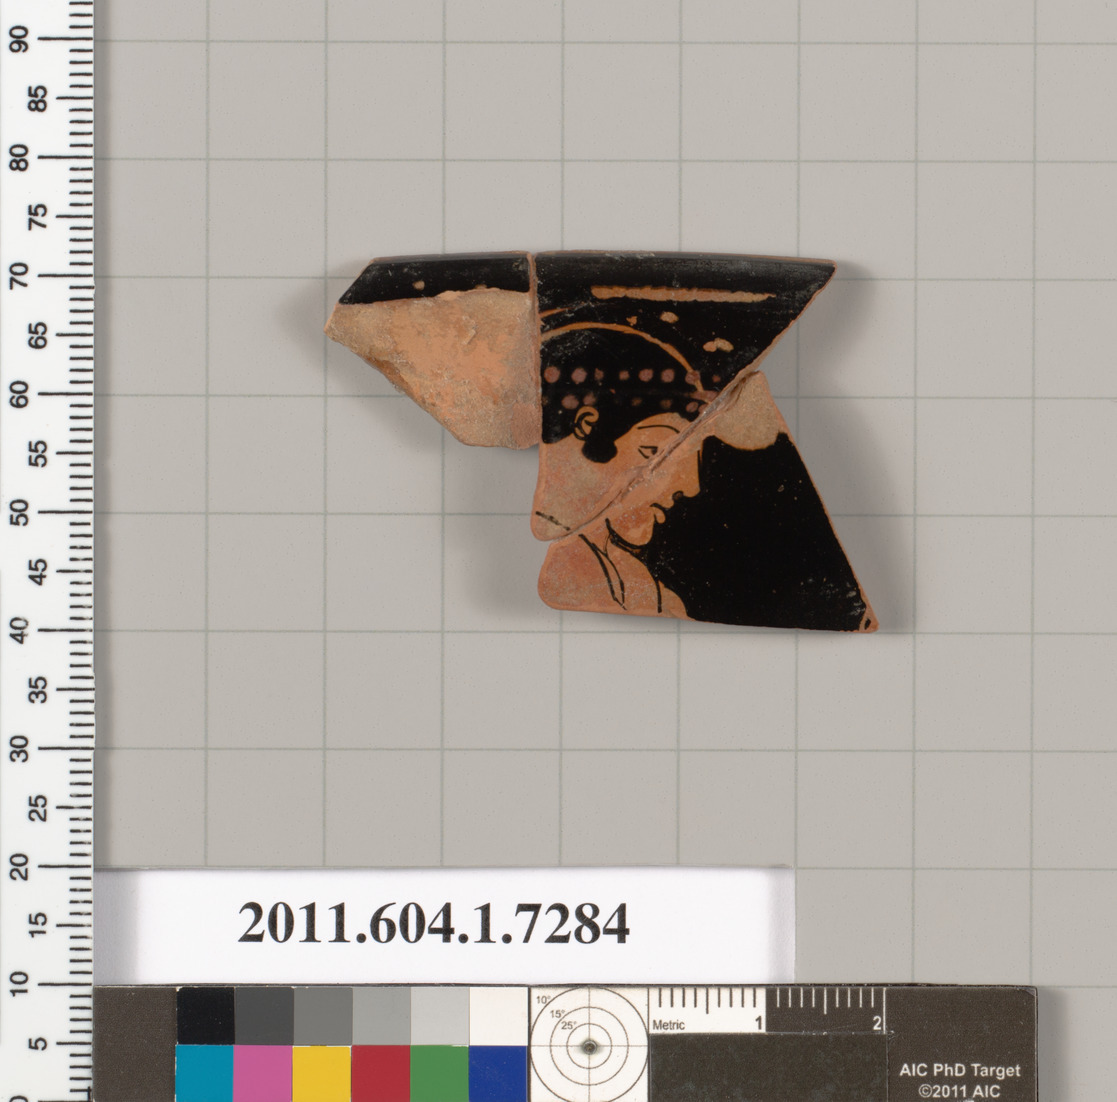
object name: kylix fragment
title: Terracotta rim fragment of a kylix (drinking cup)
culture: greek, attic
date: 500-480 BCE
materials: terracotta